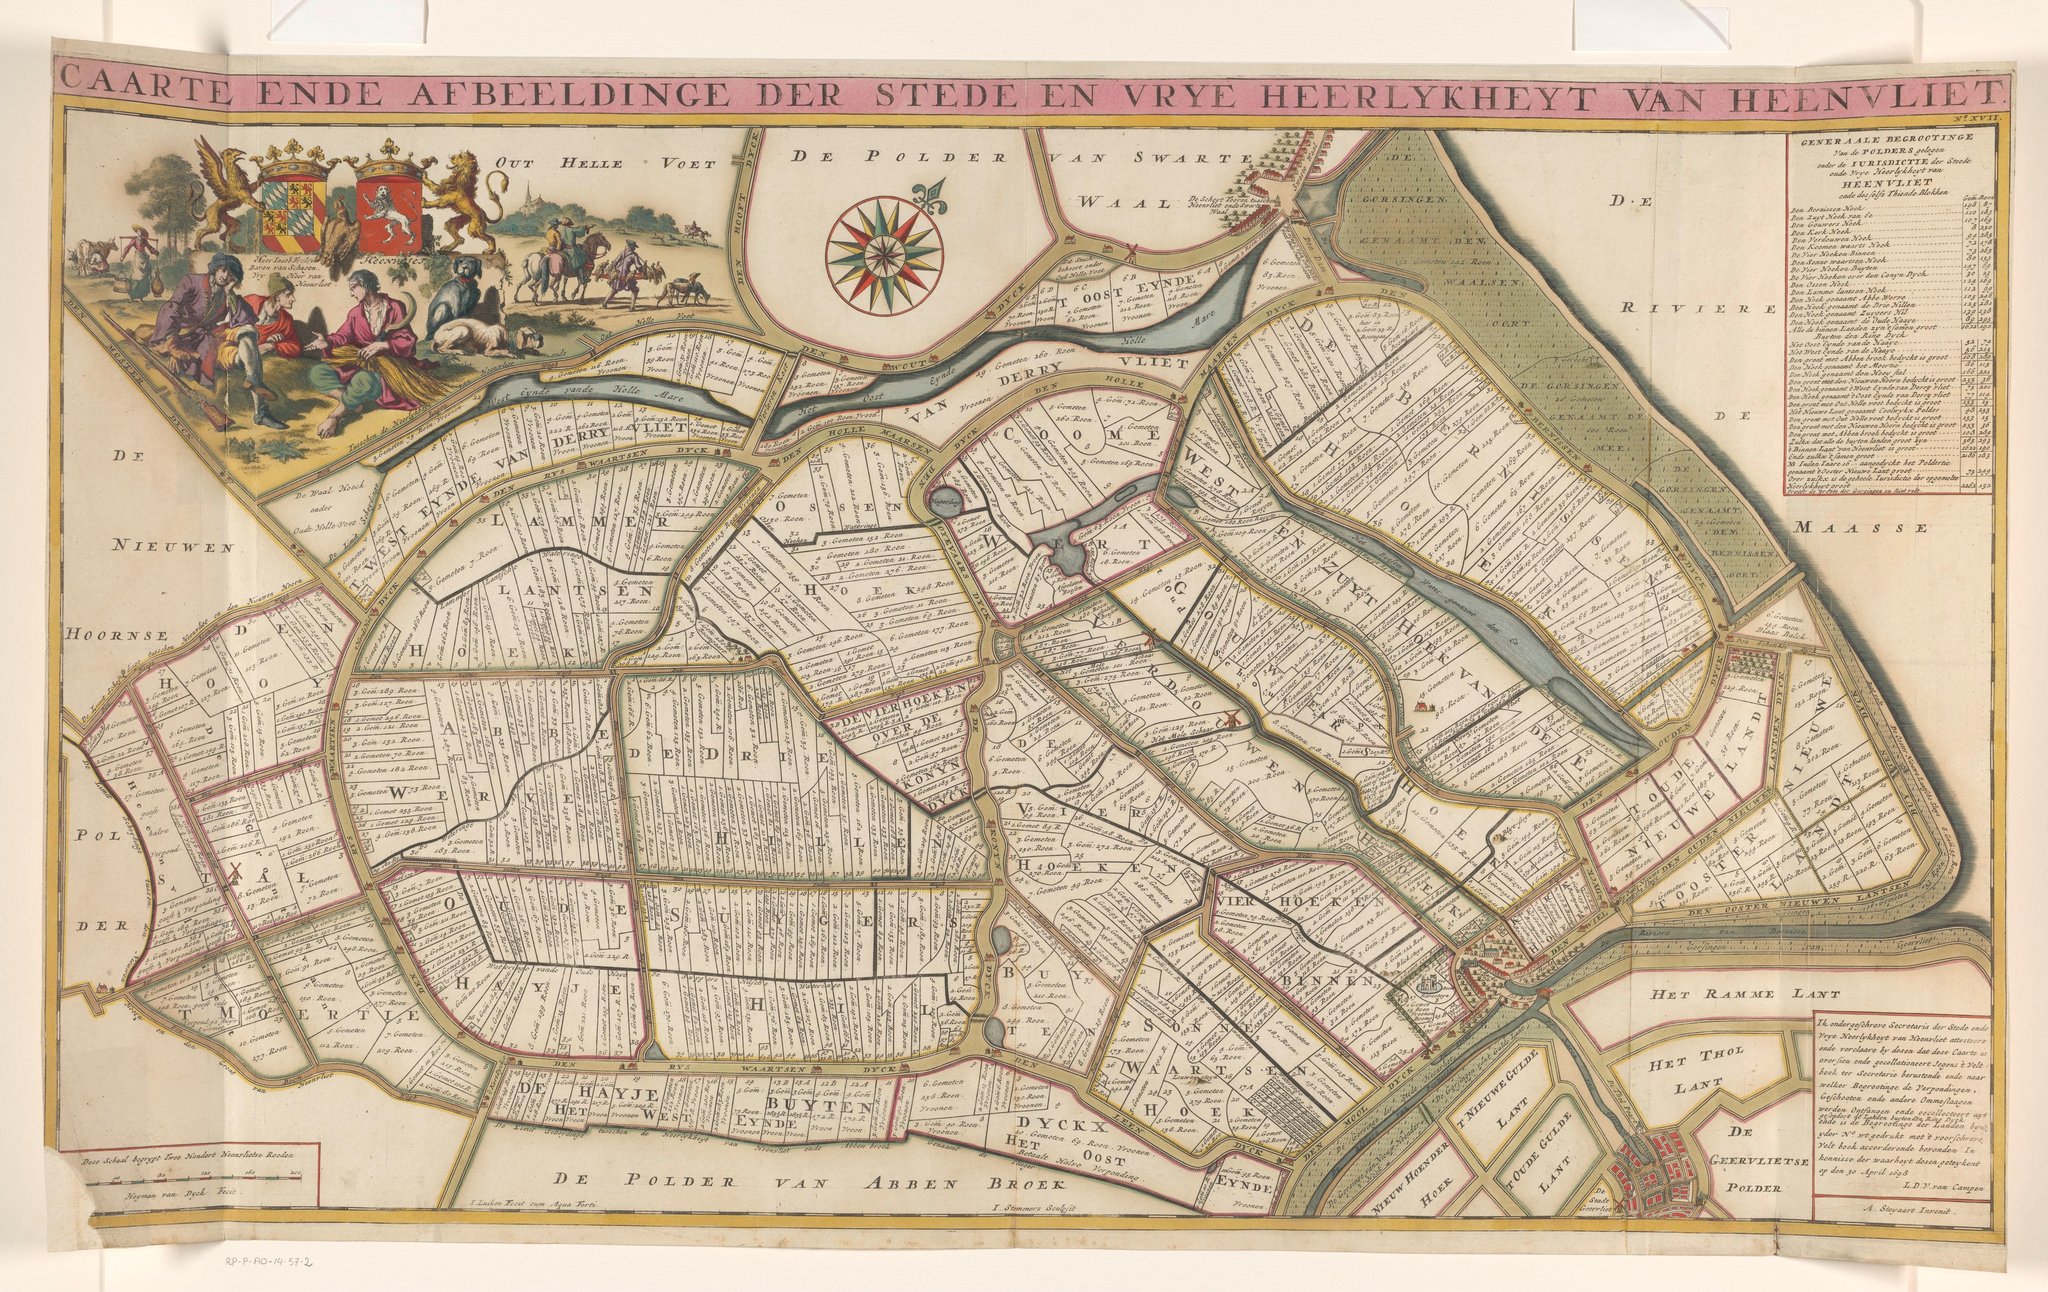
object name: map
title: Caarte ende afbeeldinge der stede en vrye heerlykheyt van Heenvliet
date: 1701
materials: paper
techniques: engraving, etching, hand coloring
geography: amsterdam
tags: coat of arms (as symbol of the state, etc.), maps of separate countries or regions, hunting, chase, hunter, farmers, carrying something with yoke, polder, reclaimed land, milkmaid, armorial bearing, heraldry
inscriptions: collector's mark: Lugt 19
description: Deze kaart is onderdeel van het zogenaamde 'Voorne Caart-boeck' / 'Caartboeck van Voorne', dat bestaat uit een titelpagina (zie RP-P-1942-347), drie algemene kaarten (van Oost-, West- en Zuid-Voorne)* en dertig detailkaarten. Het kaartboek werd vervaardigd in opdracht van de Staten van Voorne en werd in 1701 uitgegeven. Een deel van de koperplaten is bewaard gebleven en in de negentiende en twintigste eeuw gebruikt voor herdrukken. *Over de naam Voorne kan verwarring ontstaan omdat de betekenis door de eeuwen heen is veranderd. Vroeger stonden de (voormalige) eilanden Voorne, Goeree en Overflakkee – allen historisch gezien onderdeel van het Land van Voorne – bekend als respectievelijk Oost-, West- en Zuid-Voorne.